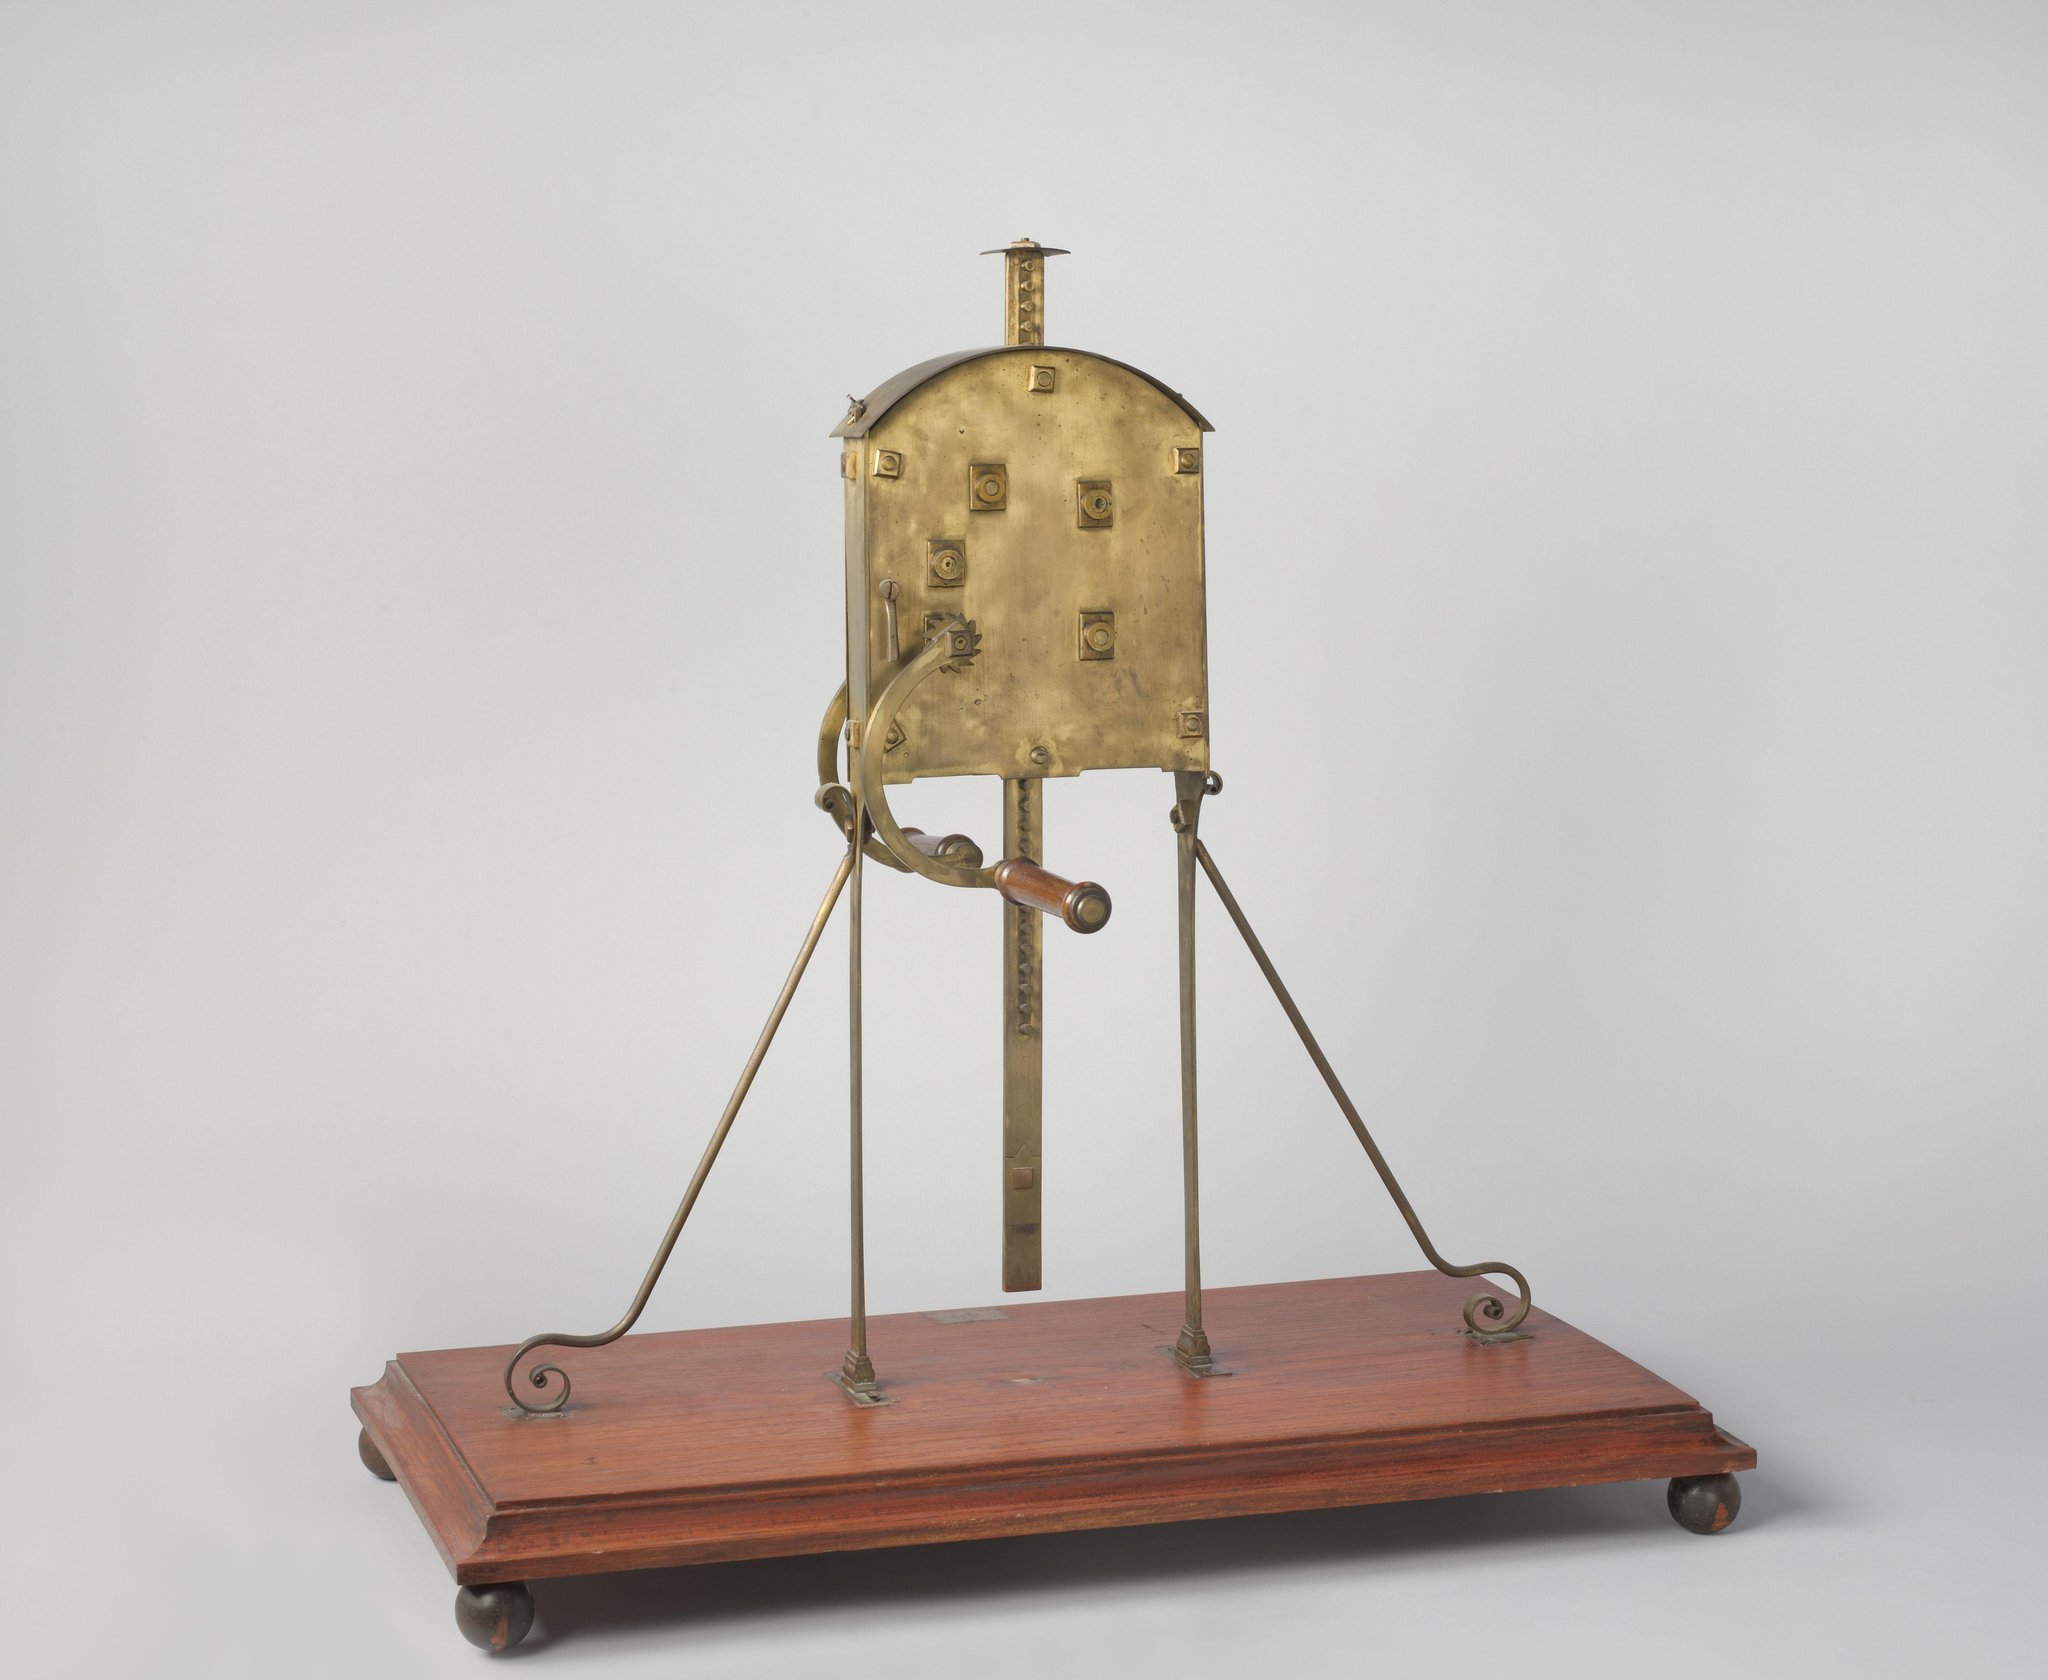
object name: demonstration model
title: Model of the Paddle Gear of the Lock at Flushing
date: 1837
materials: brass, iron, wood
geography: flushing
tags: flushing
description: Model van een lier voor het bedienen van de spuien van sluisdeuren, op een grondplank. De lier staat op vier poten. Met een zwengel aan weerszijden wordt een raderwerk binnenin aangedreven, waardoor een heugel met ronde pennen in plaats van tanden omhoog en omlaag bewogen wordt. Een tandwiel met pal aan één kant voorkomt het teruglopen van de lier. Schaal 1:3 (afgeleid).